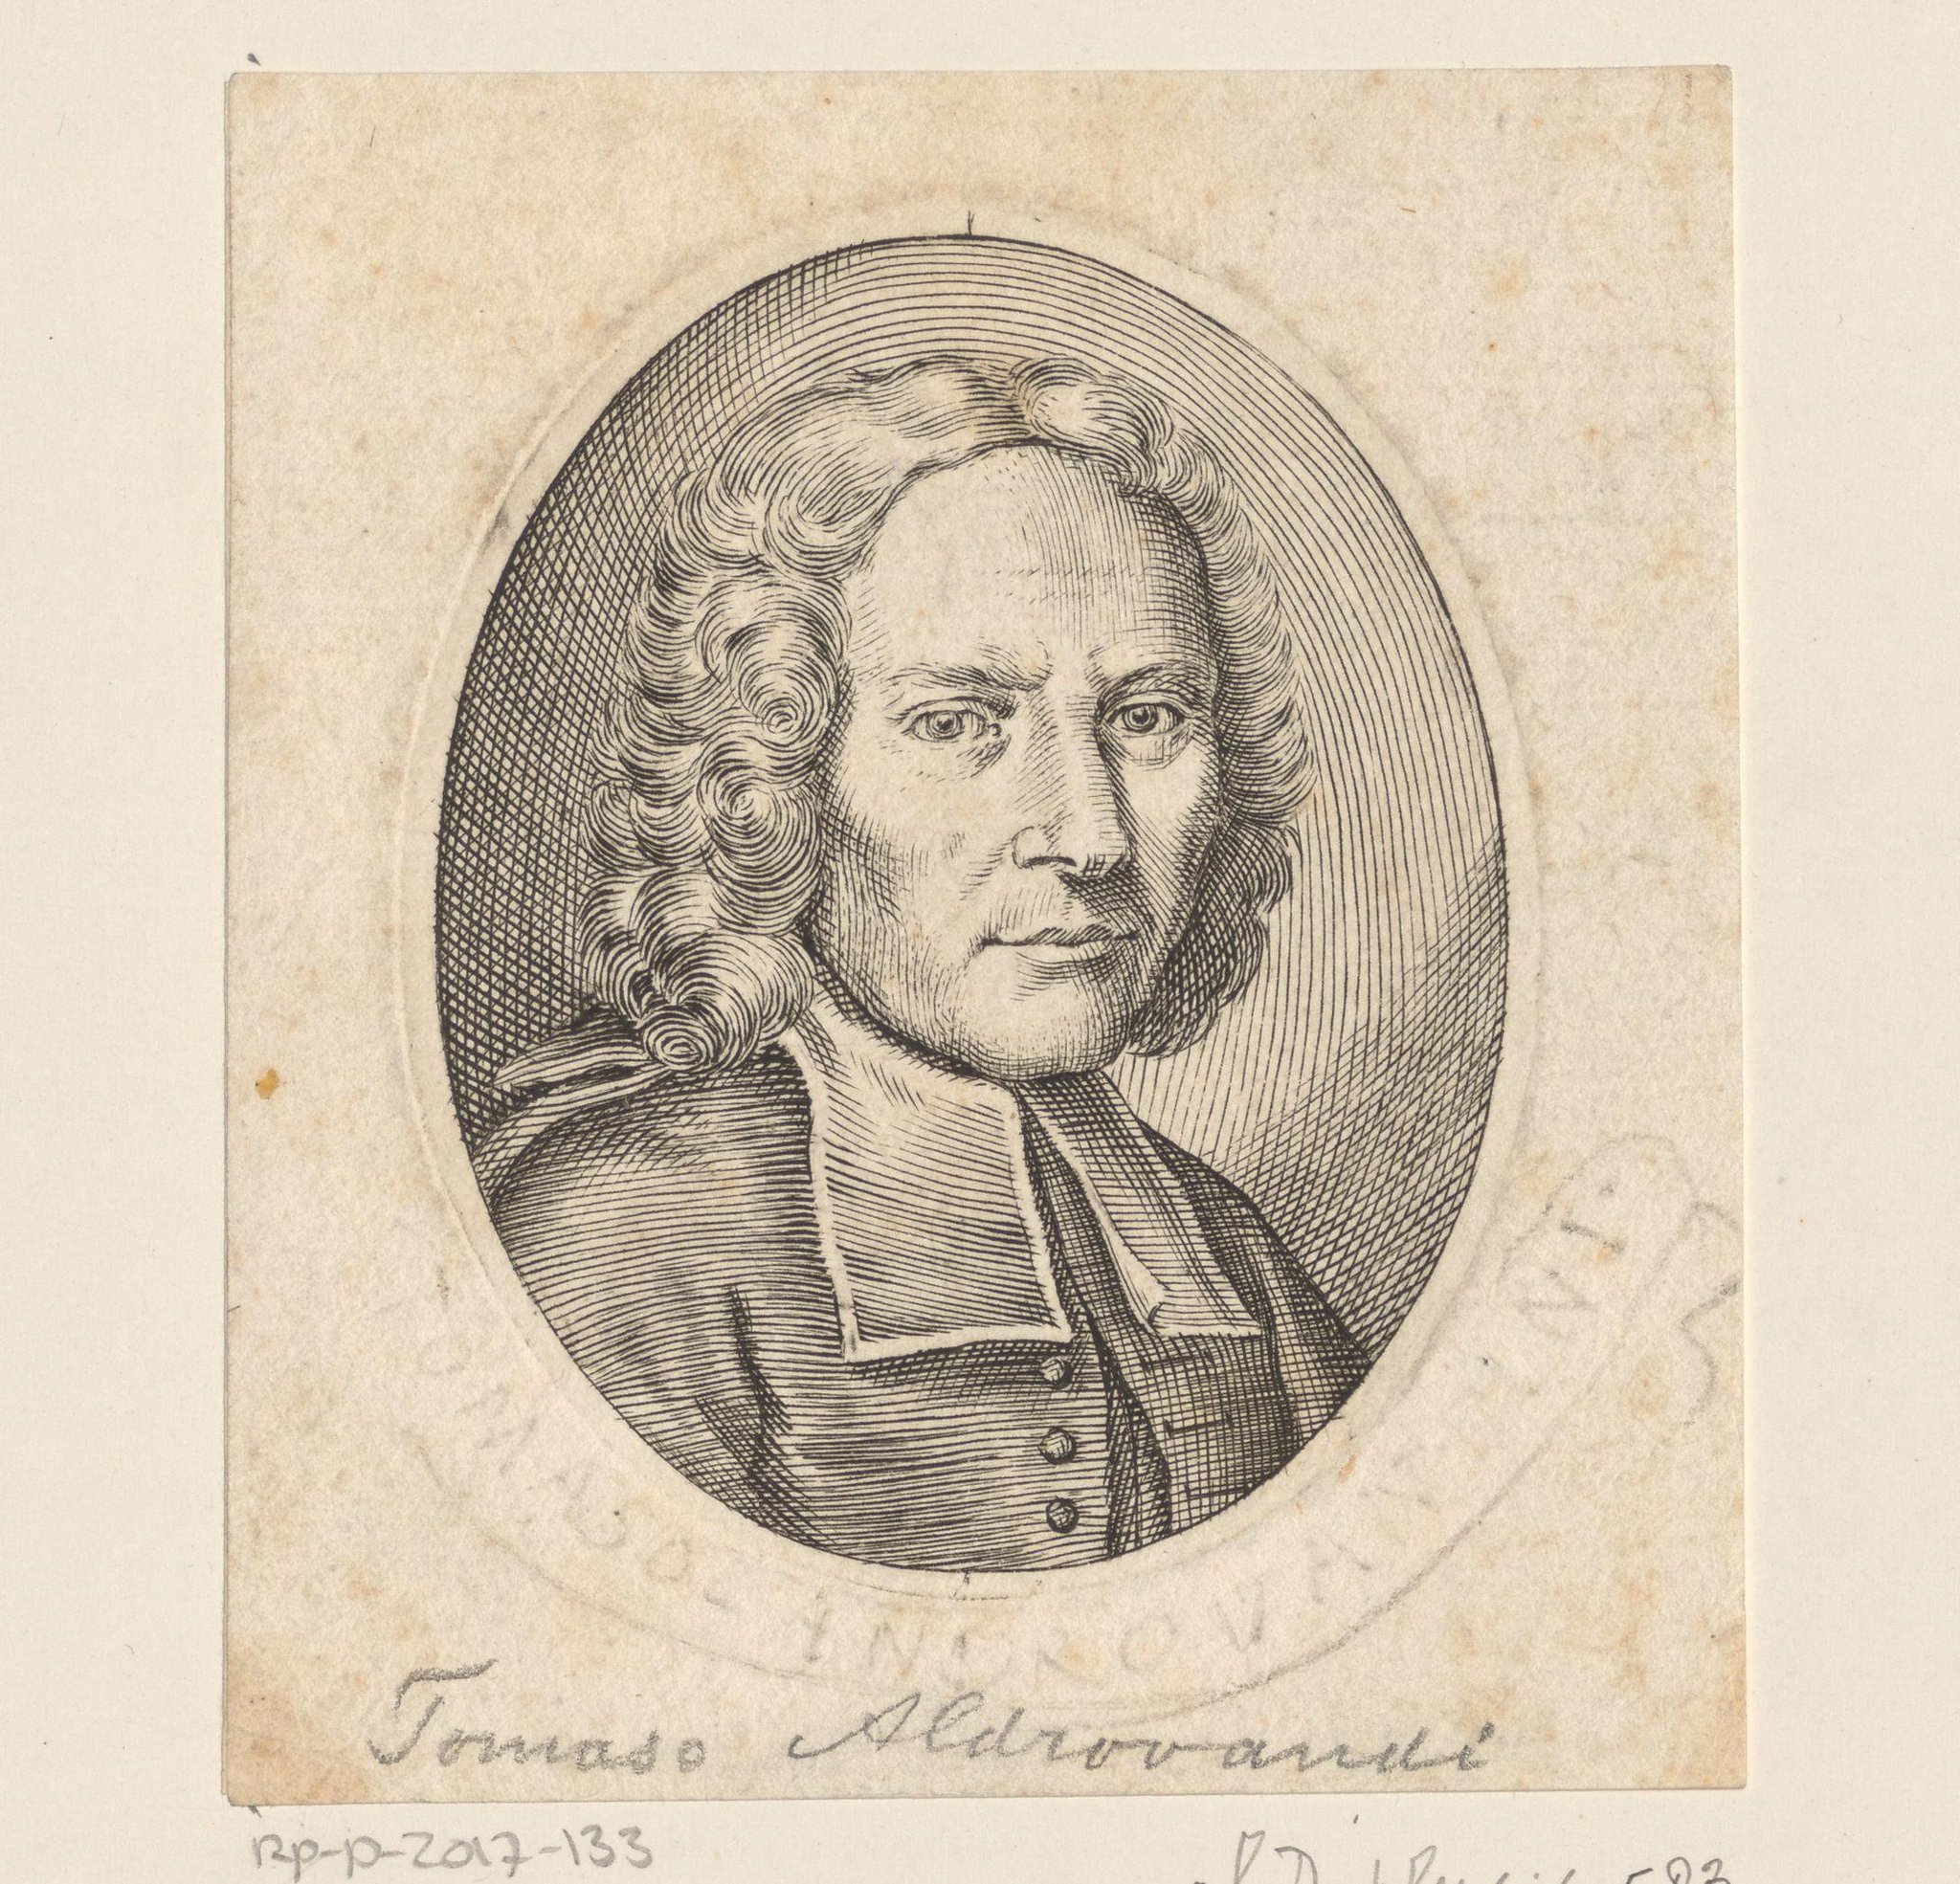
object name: print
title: Portret van Tommaso Aldrovandini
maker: Anonymous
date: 1700-1799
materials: paper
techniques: engraving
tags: painter